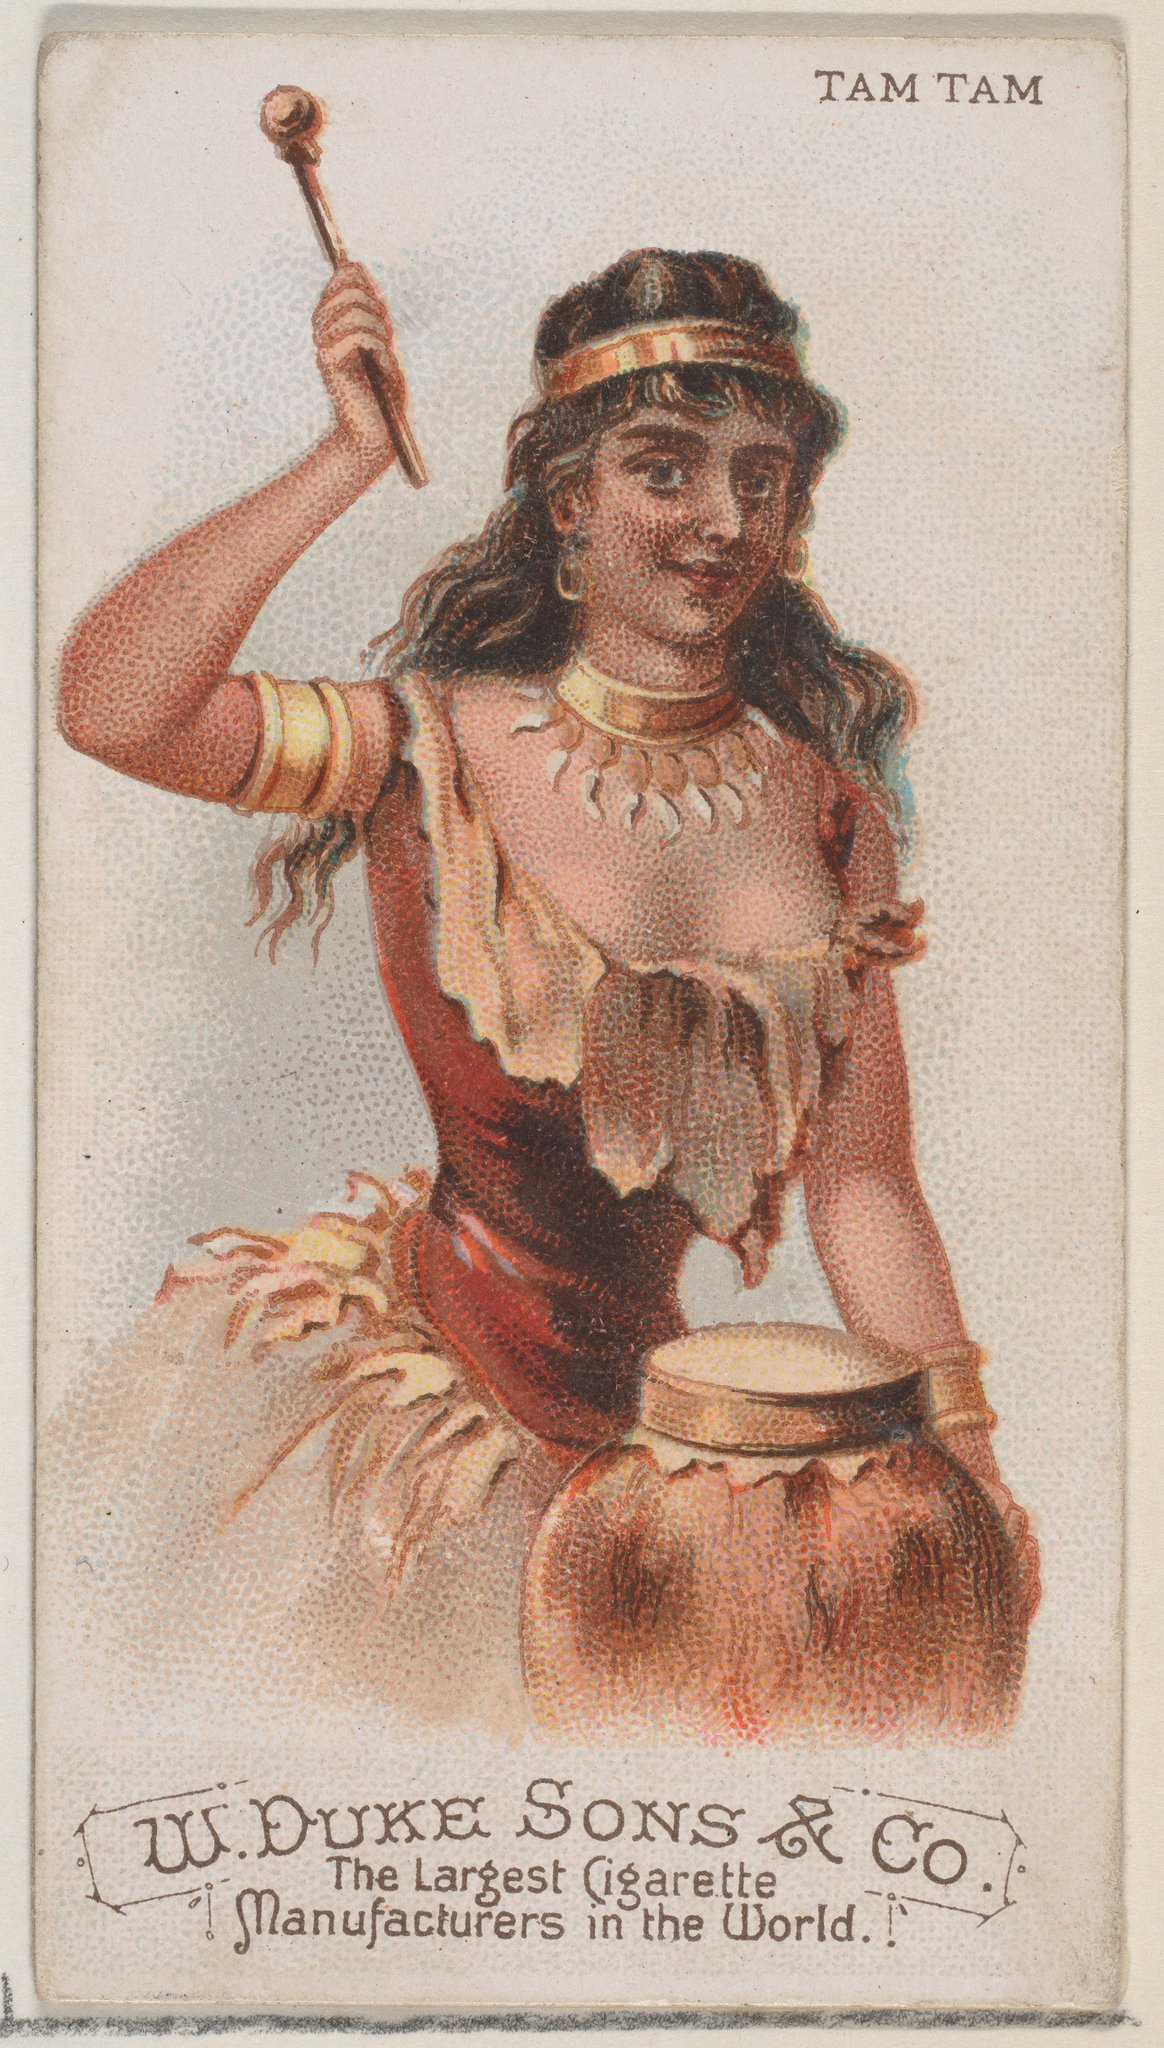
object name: print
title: Tam Tam, from the Musical Instruments series (N82) for Duke brand cigarettes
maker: w. duke, sons & co.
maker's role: publisher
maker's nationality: american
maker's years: 1870-1920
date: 1888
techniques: color lithograph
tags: musical instruments,women,musicians